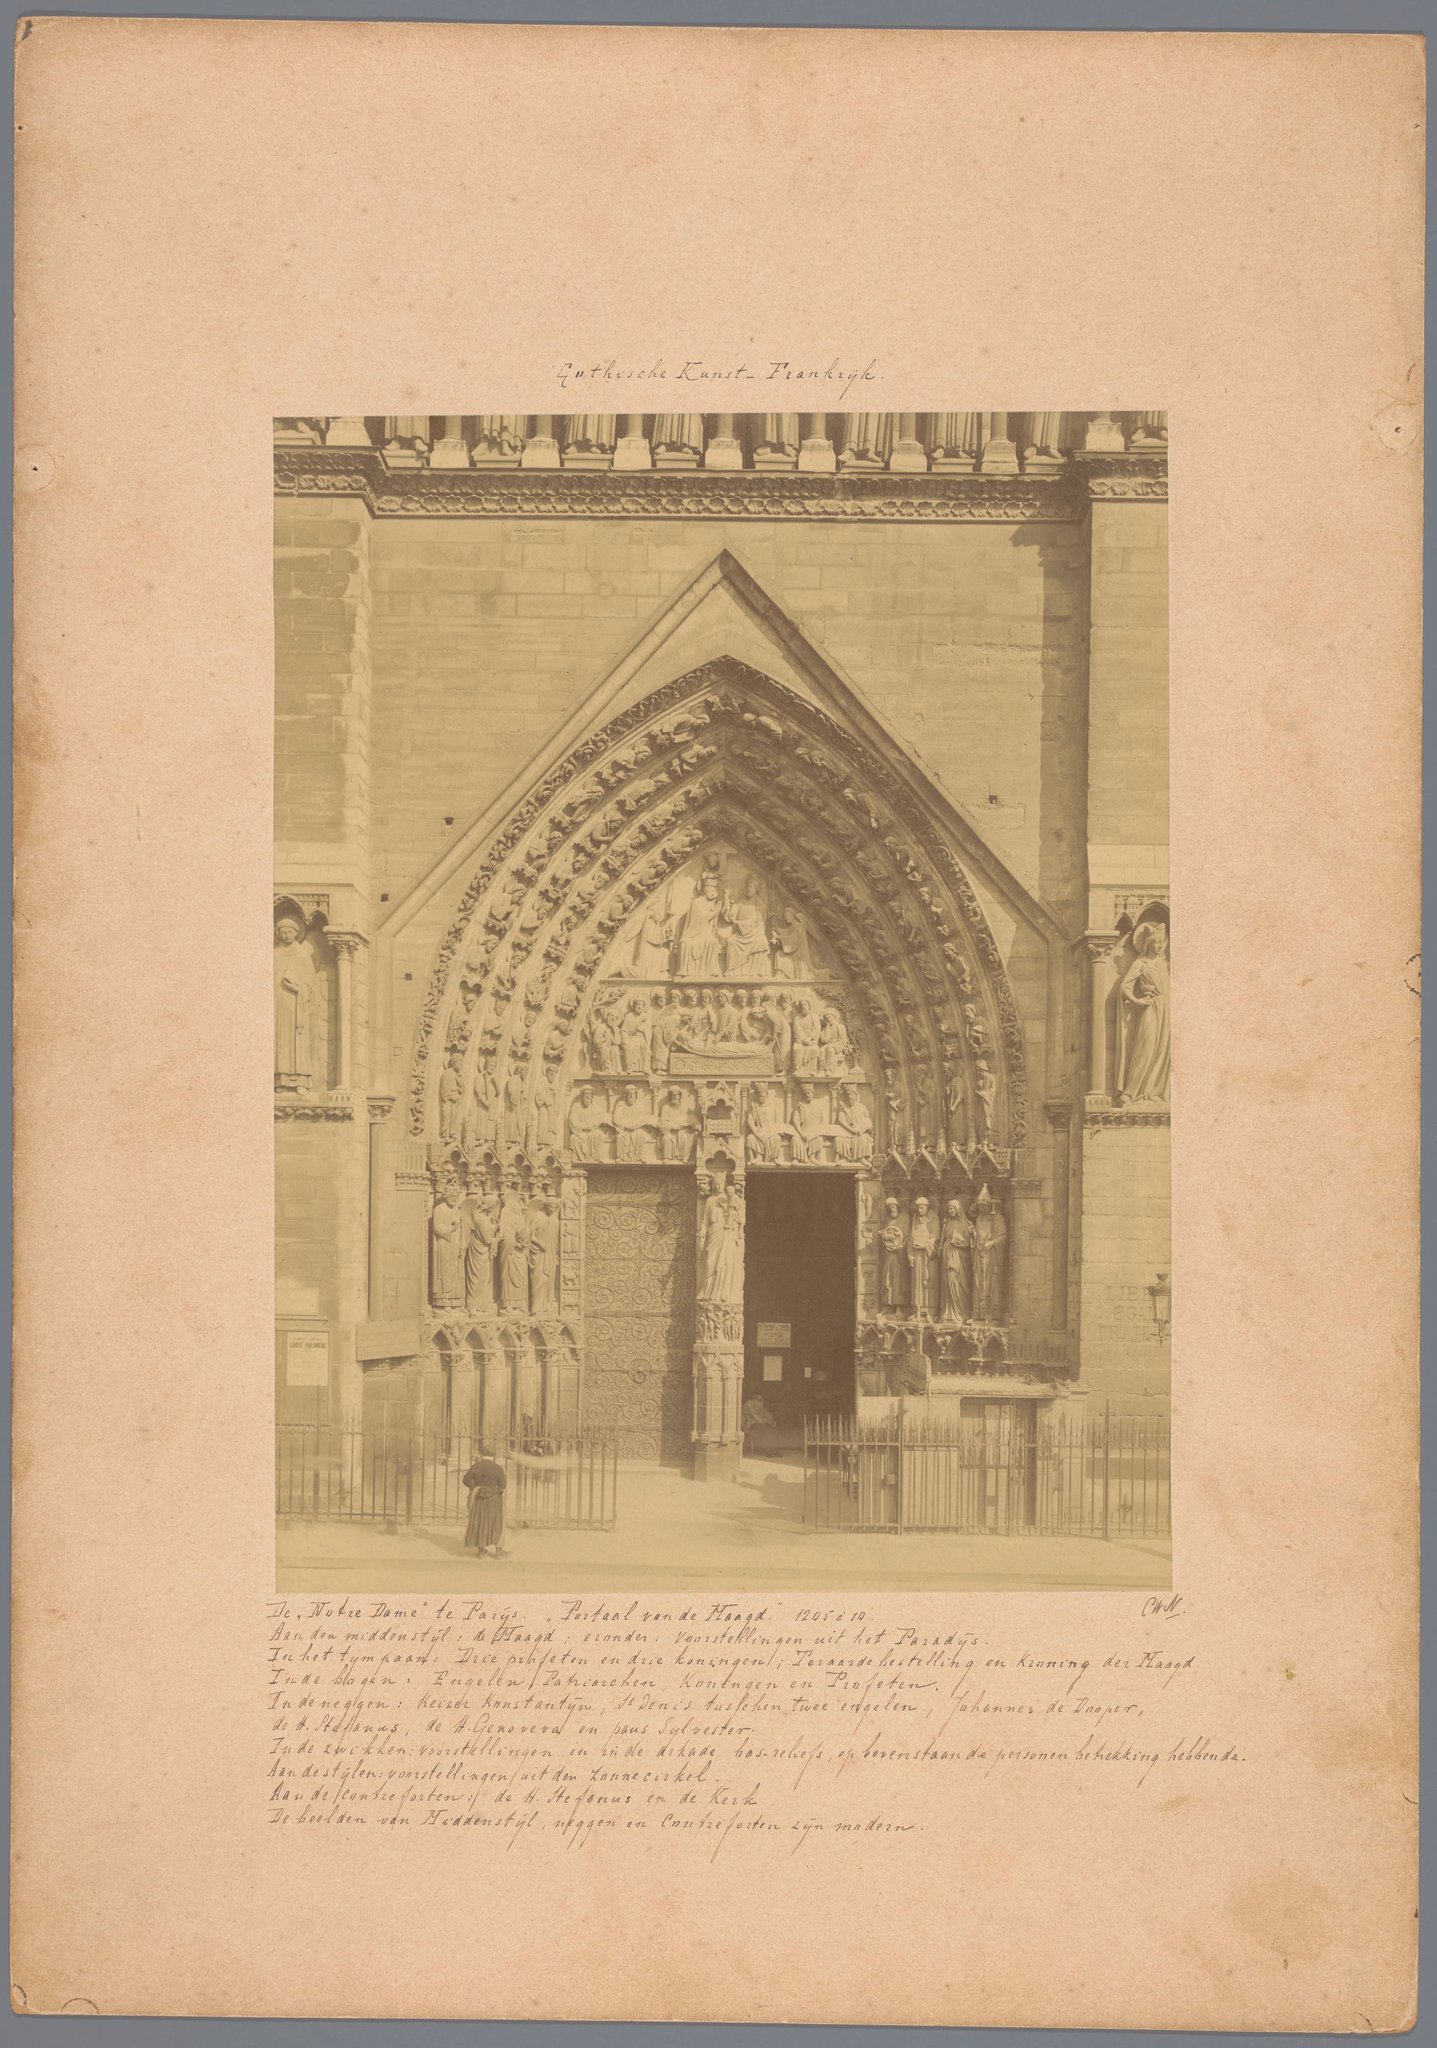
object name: photograph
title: De ,, Notre Dame" te Parijs, ,,Portaal van de Maagd"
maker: Anonymous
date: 1875-1900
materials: cardboard, photographic support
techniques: albumen print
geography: paris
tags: parts of church exterior and annexes: portal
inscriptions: inscription: ‘CWN.’, collector's mark: ‘INSTITUUT VOOR KUNST-NIJVERHEIDSONDERWIJS GABRIËL METSUSTRAAT No. 16 AMSTERDAM’, inscription: ‘Gothische Kunst - Frankrijk.’